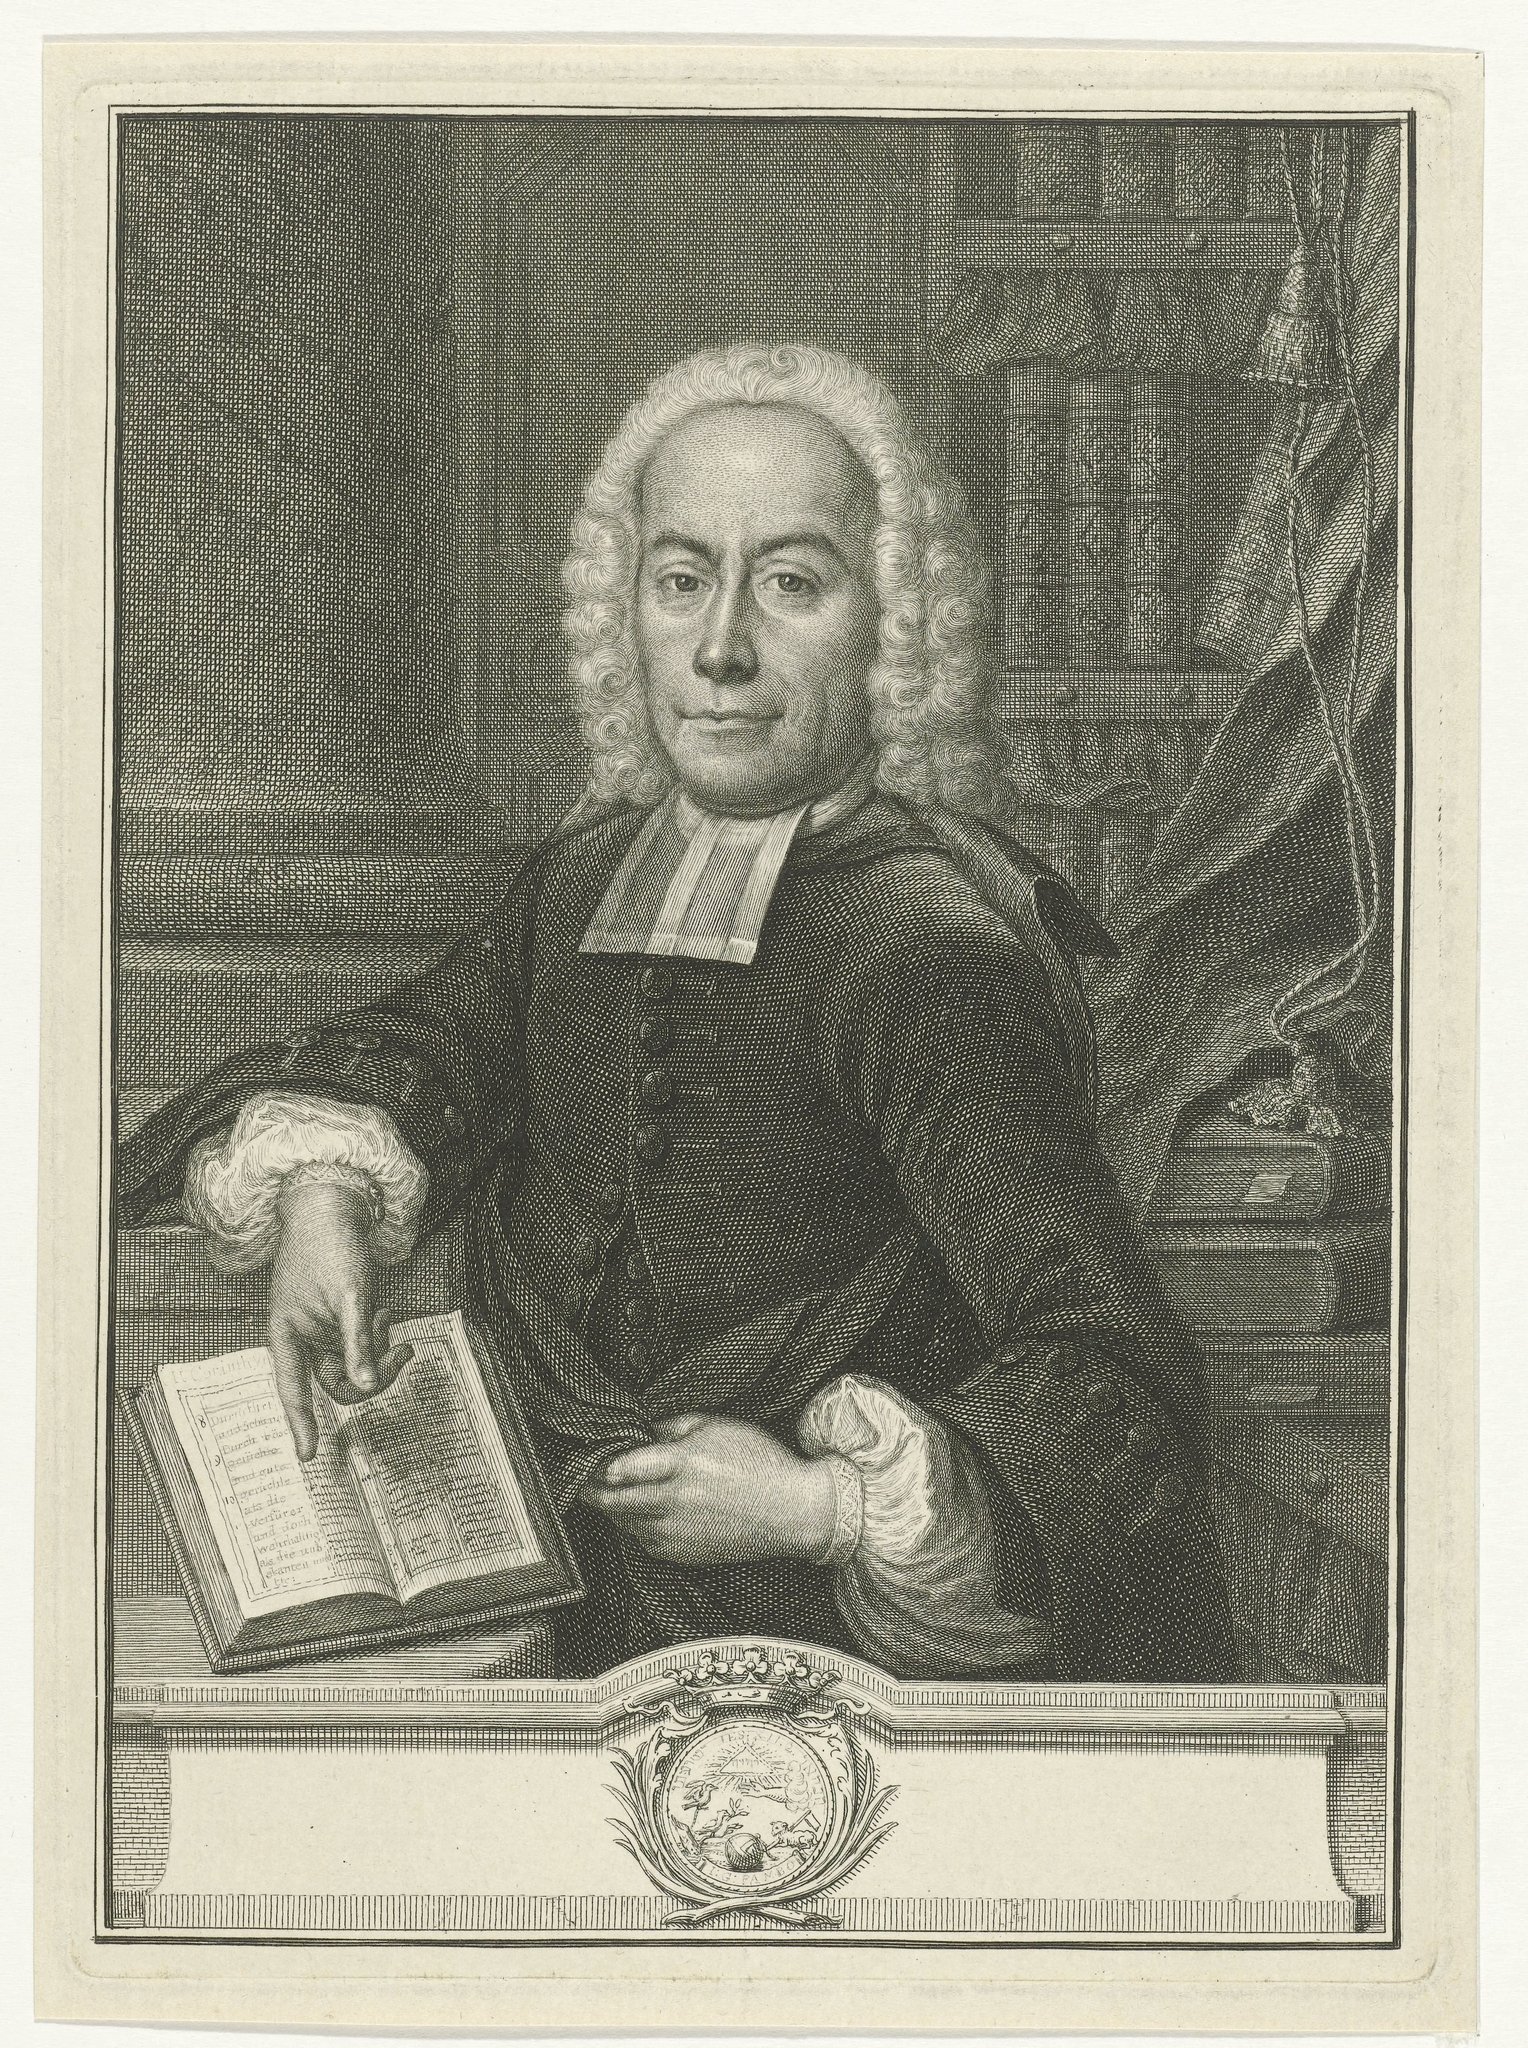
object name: print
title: Portret van Johann Gotlieb Pambo op 55-jarige leeftijd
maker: jacob folkema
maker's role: draughtsman, print maker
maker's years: 1692-1767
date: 1751-1767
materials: paper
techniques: engraving, etching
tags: berlin, the hague, adult man, historical persons, book - mm - book open, study; 'studiolo'; library, functionaries and dignitaries ~ protestant churches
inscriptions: collector's mark: Lugt 964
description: Portret ten halven lijve naar rechts van de predikant Johann Gotlieb Pambo, gehuld in een toga. Met zijn rechterhand wijst hij op een opengeslagen bijbel. Onder het portret staat in het midden van de sokkel een gekroond medaillon met christelijke symbolen.